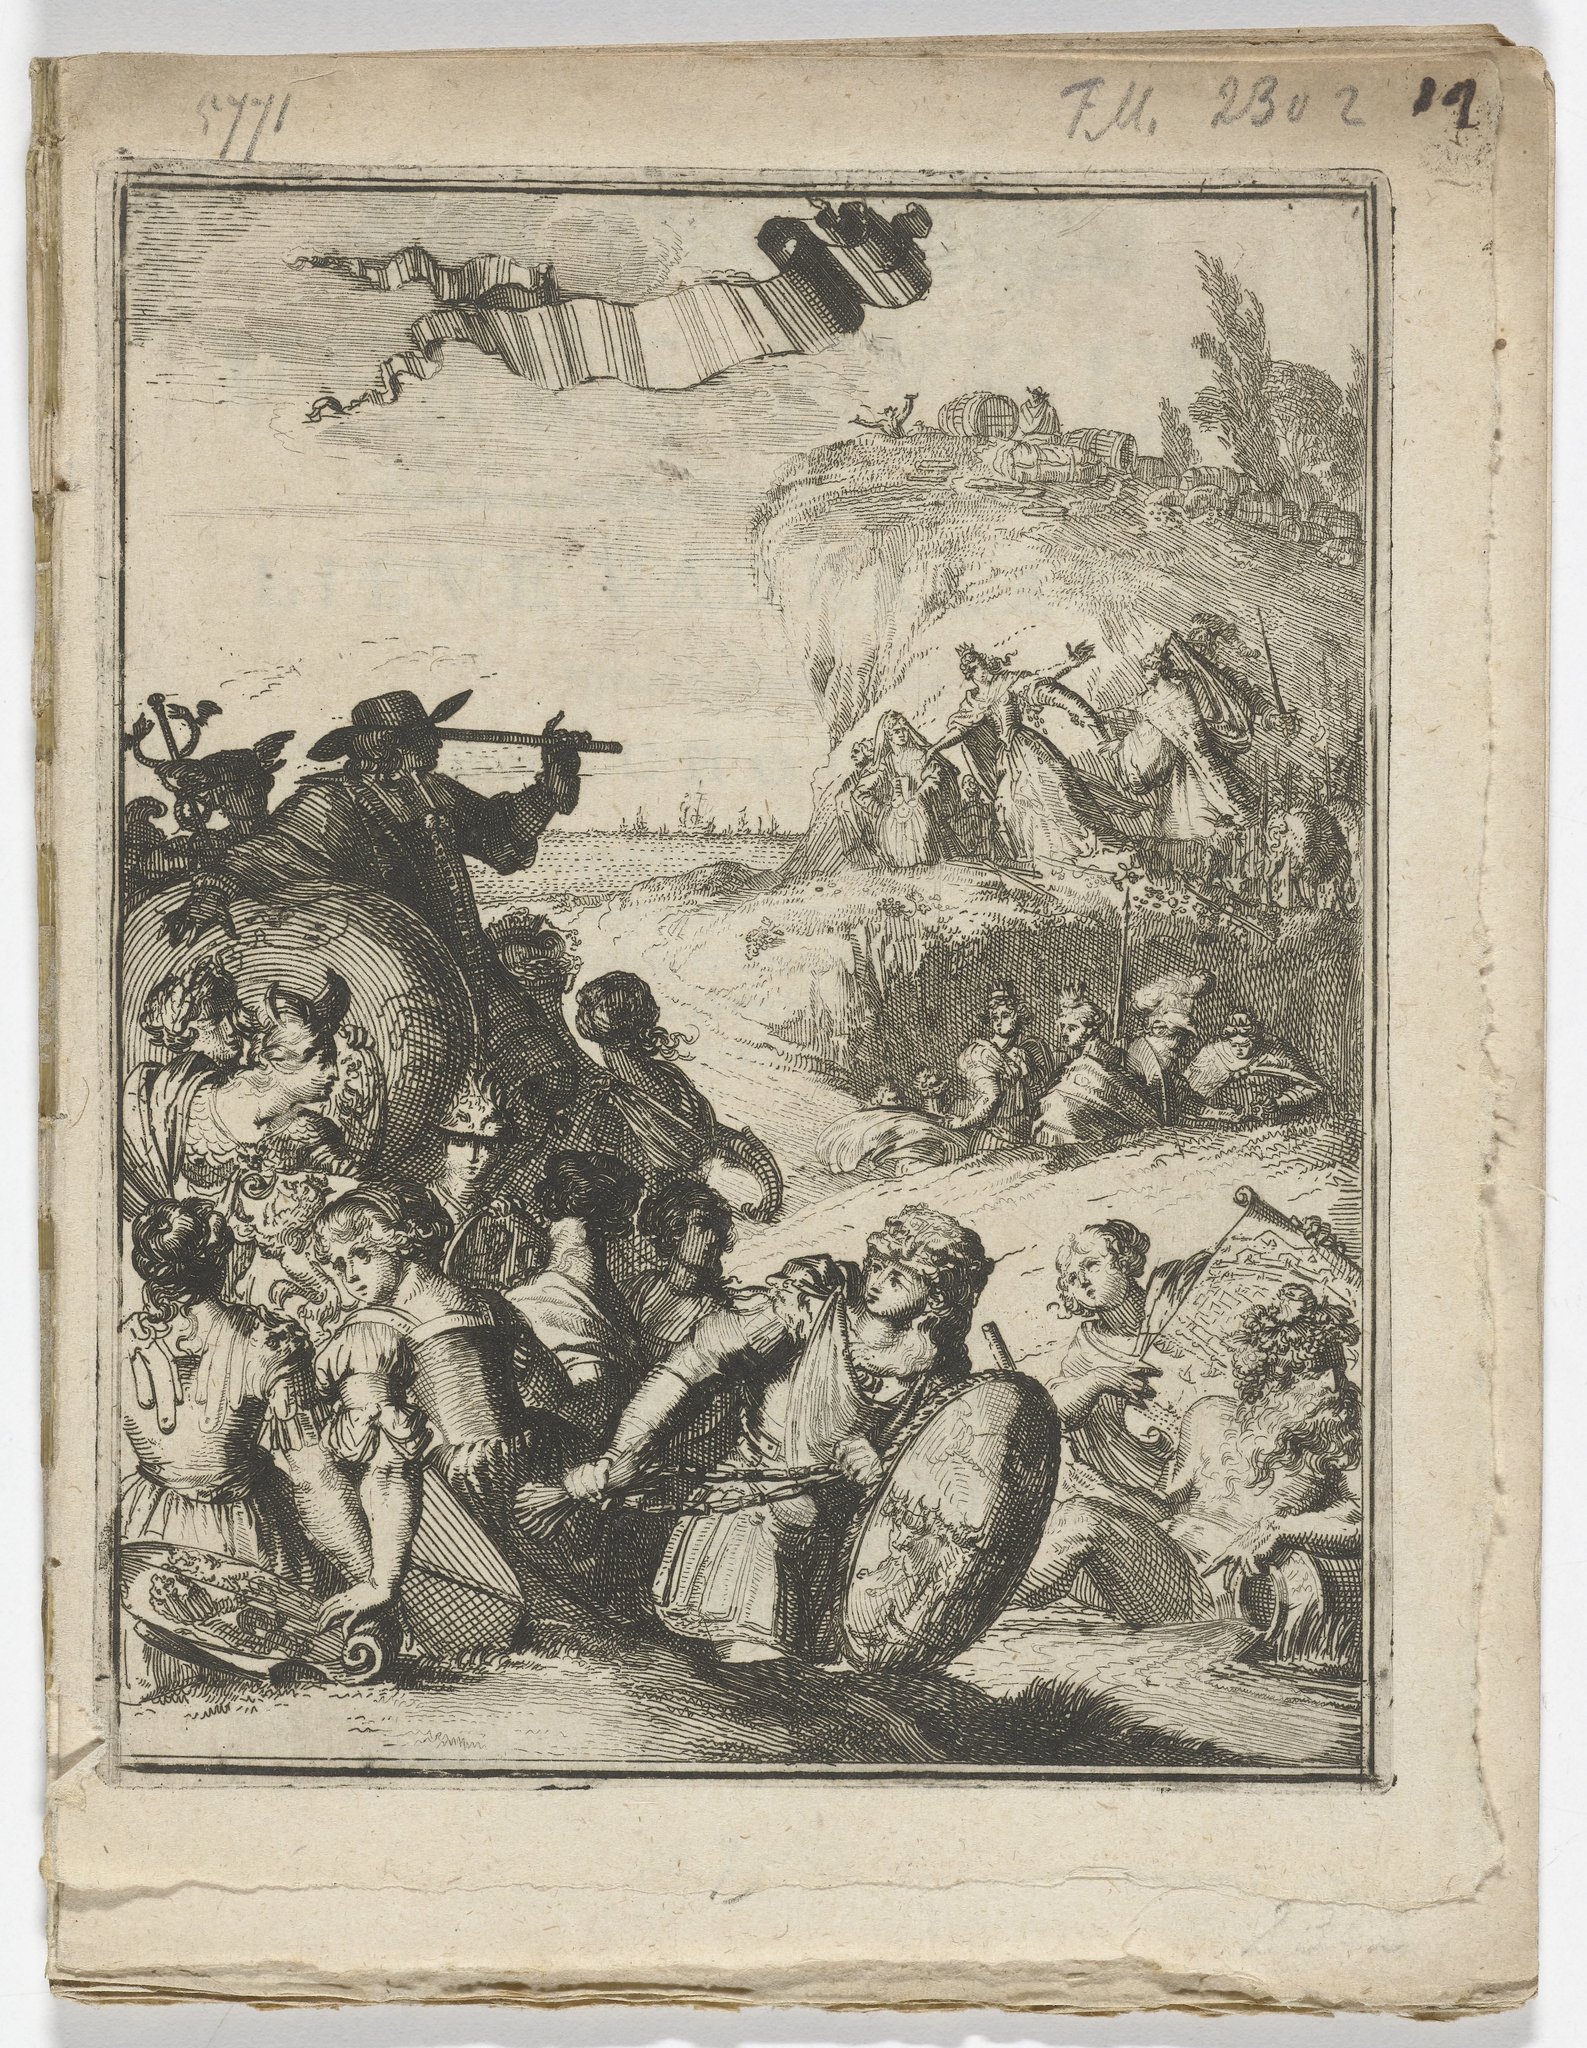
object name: pamphlet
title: Den Hollandschen Verre-Kyker. Verhalende den tegenwoordigen toestant van ons Lieve Vaderland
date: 1671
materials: paper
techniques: etching, letterpress printing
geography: utrecht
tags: telescope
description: Pamflet getiteld: Den Hollandschen Verre-Kyker, 1671. Met allegorische titelprent met een Hollander die, geleund tegen de wereldbol, met een verrekijker kijkt, achter hem staat Mercurius, op de voorgrond Eendracht van het land en andere allegorische figuren. Titelprent van een pamflet van 28 bladzijden in het Nederlands waarin een samenspraak tussen een Hollander, Fransman en Engelsman over situatie in Europa tussen 1668-1671.